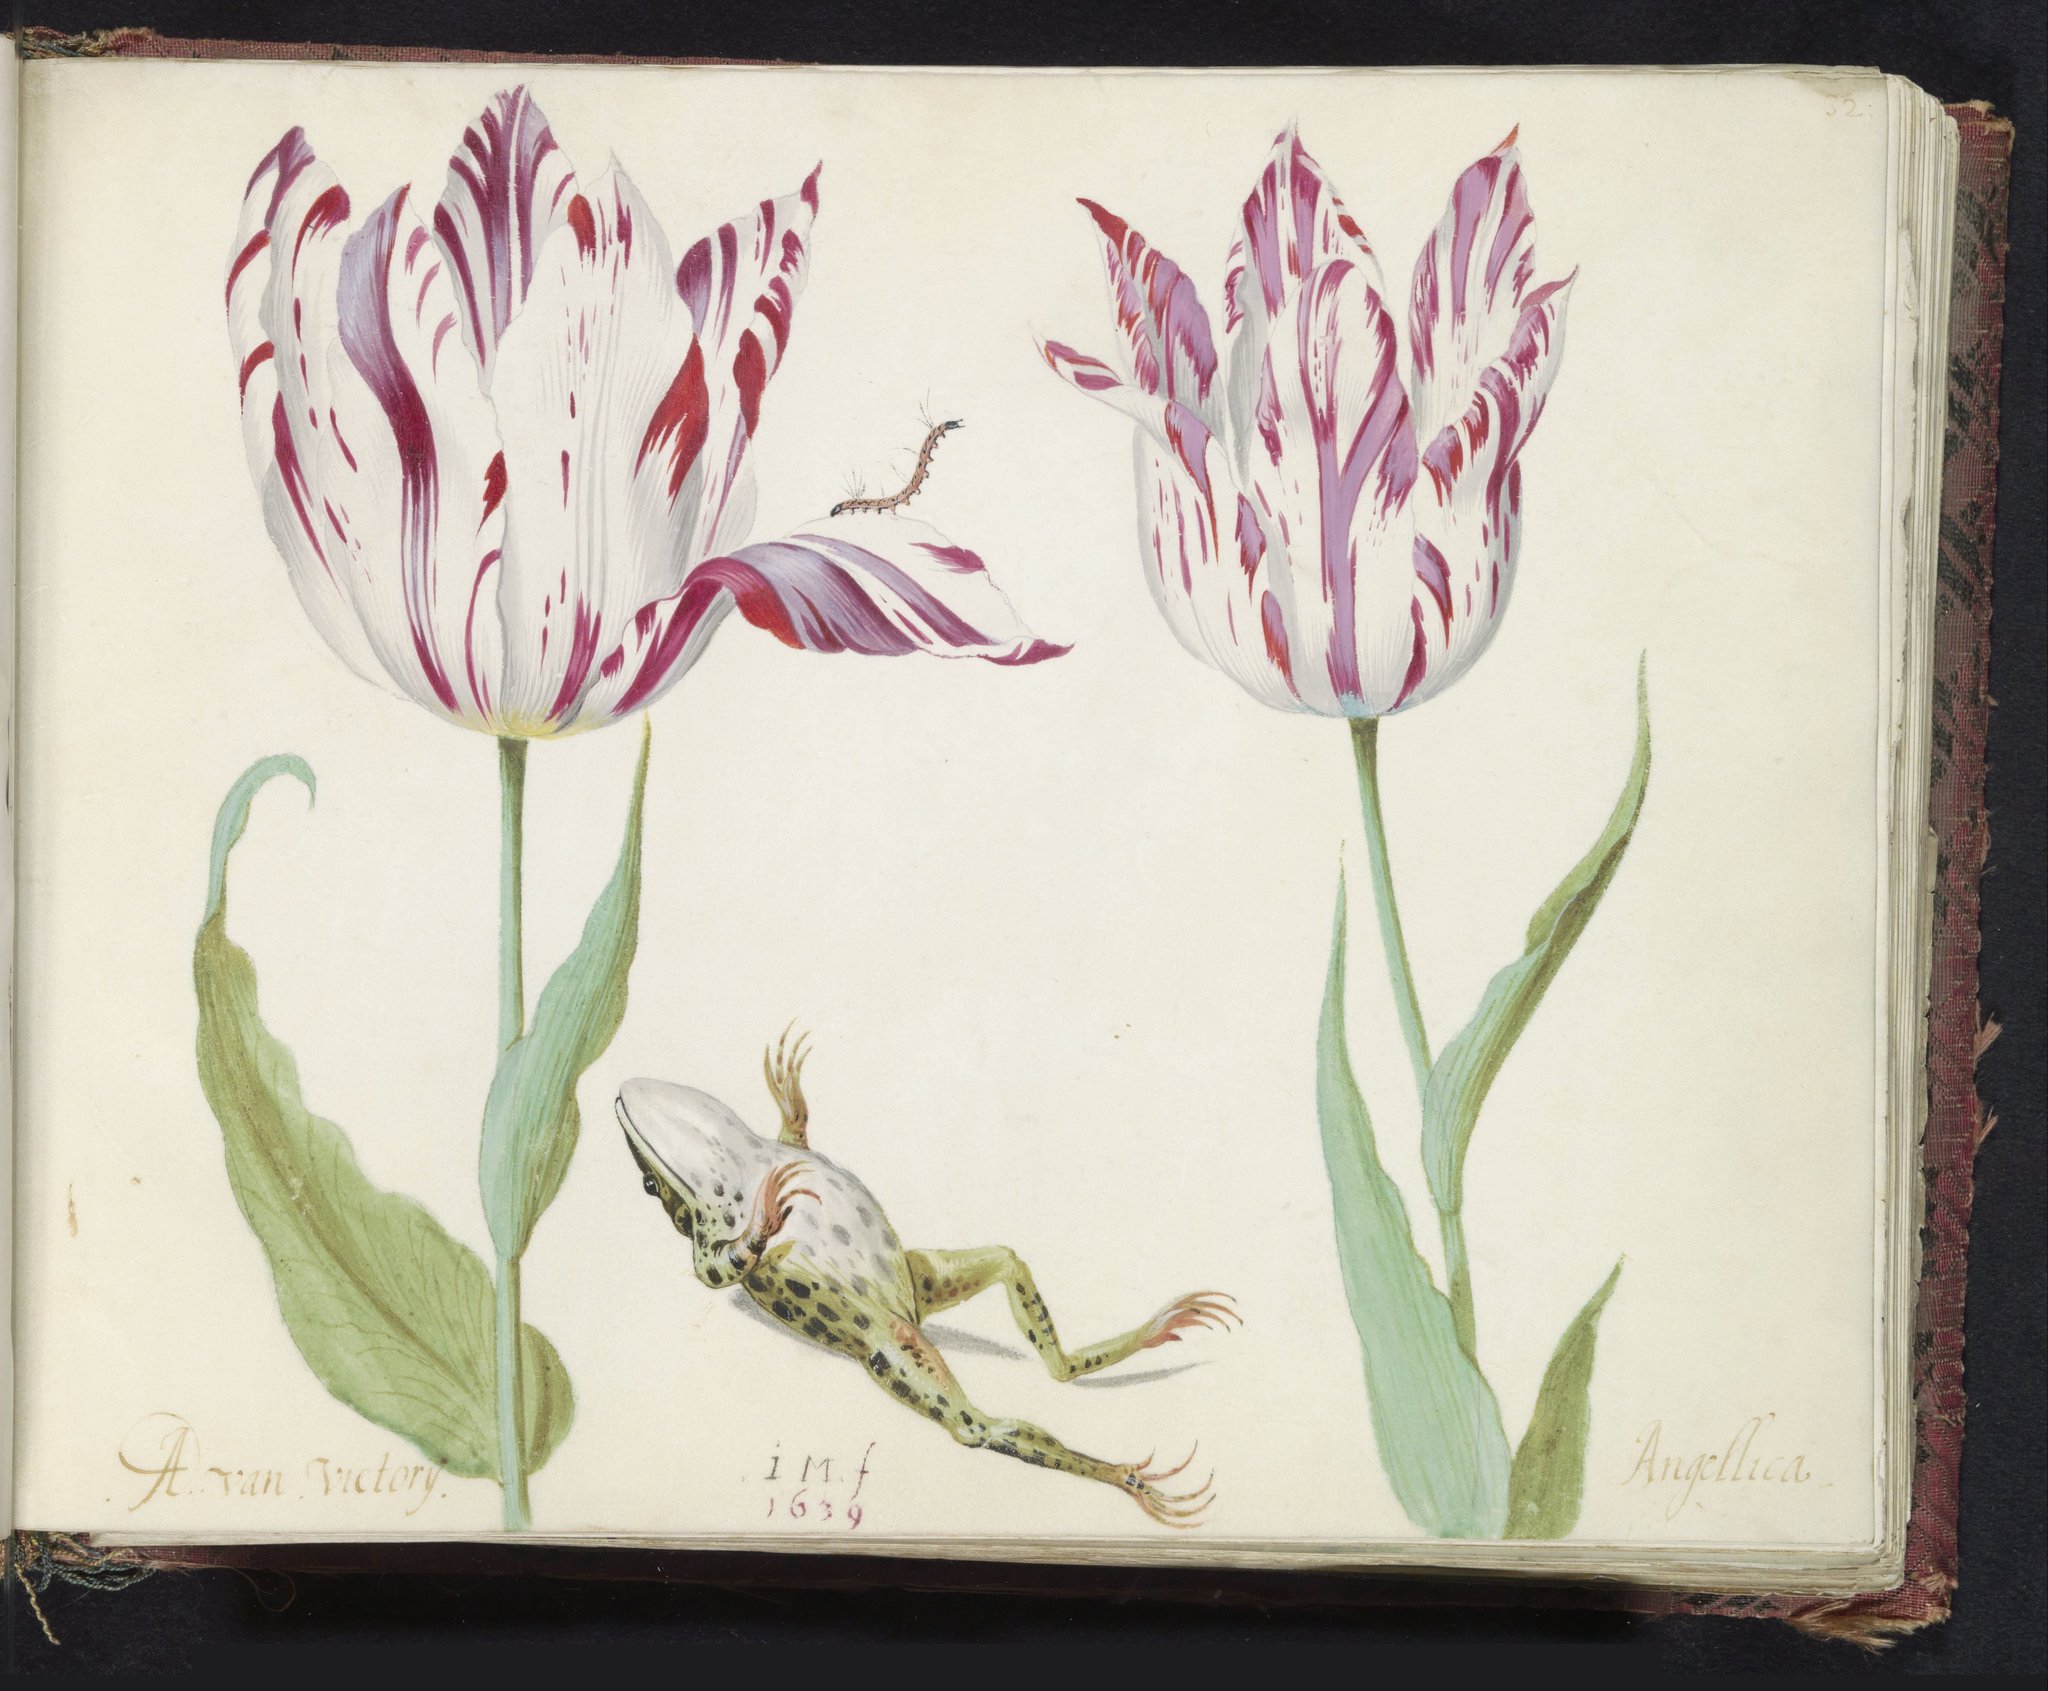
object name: drawing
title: Twee tulpen met dode kiker en rups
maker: jacob marrel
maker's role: draughtsman, painter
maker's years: 1614-1681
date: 1639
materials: paint, parchment, pencil, watercolor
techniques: brush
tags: tailless amphibians: frog, flowers: tulip, insects: caterpillar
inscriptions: date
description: De tekening maakt deel uit van een album.